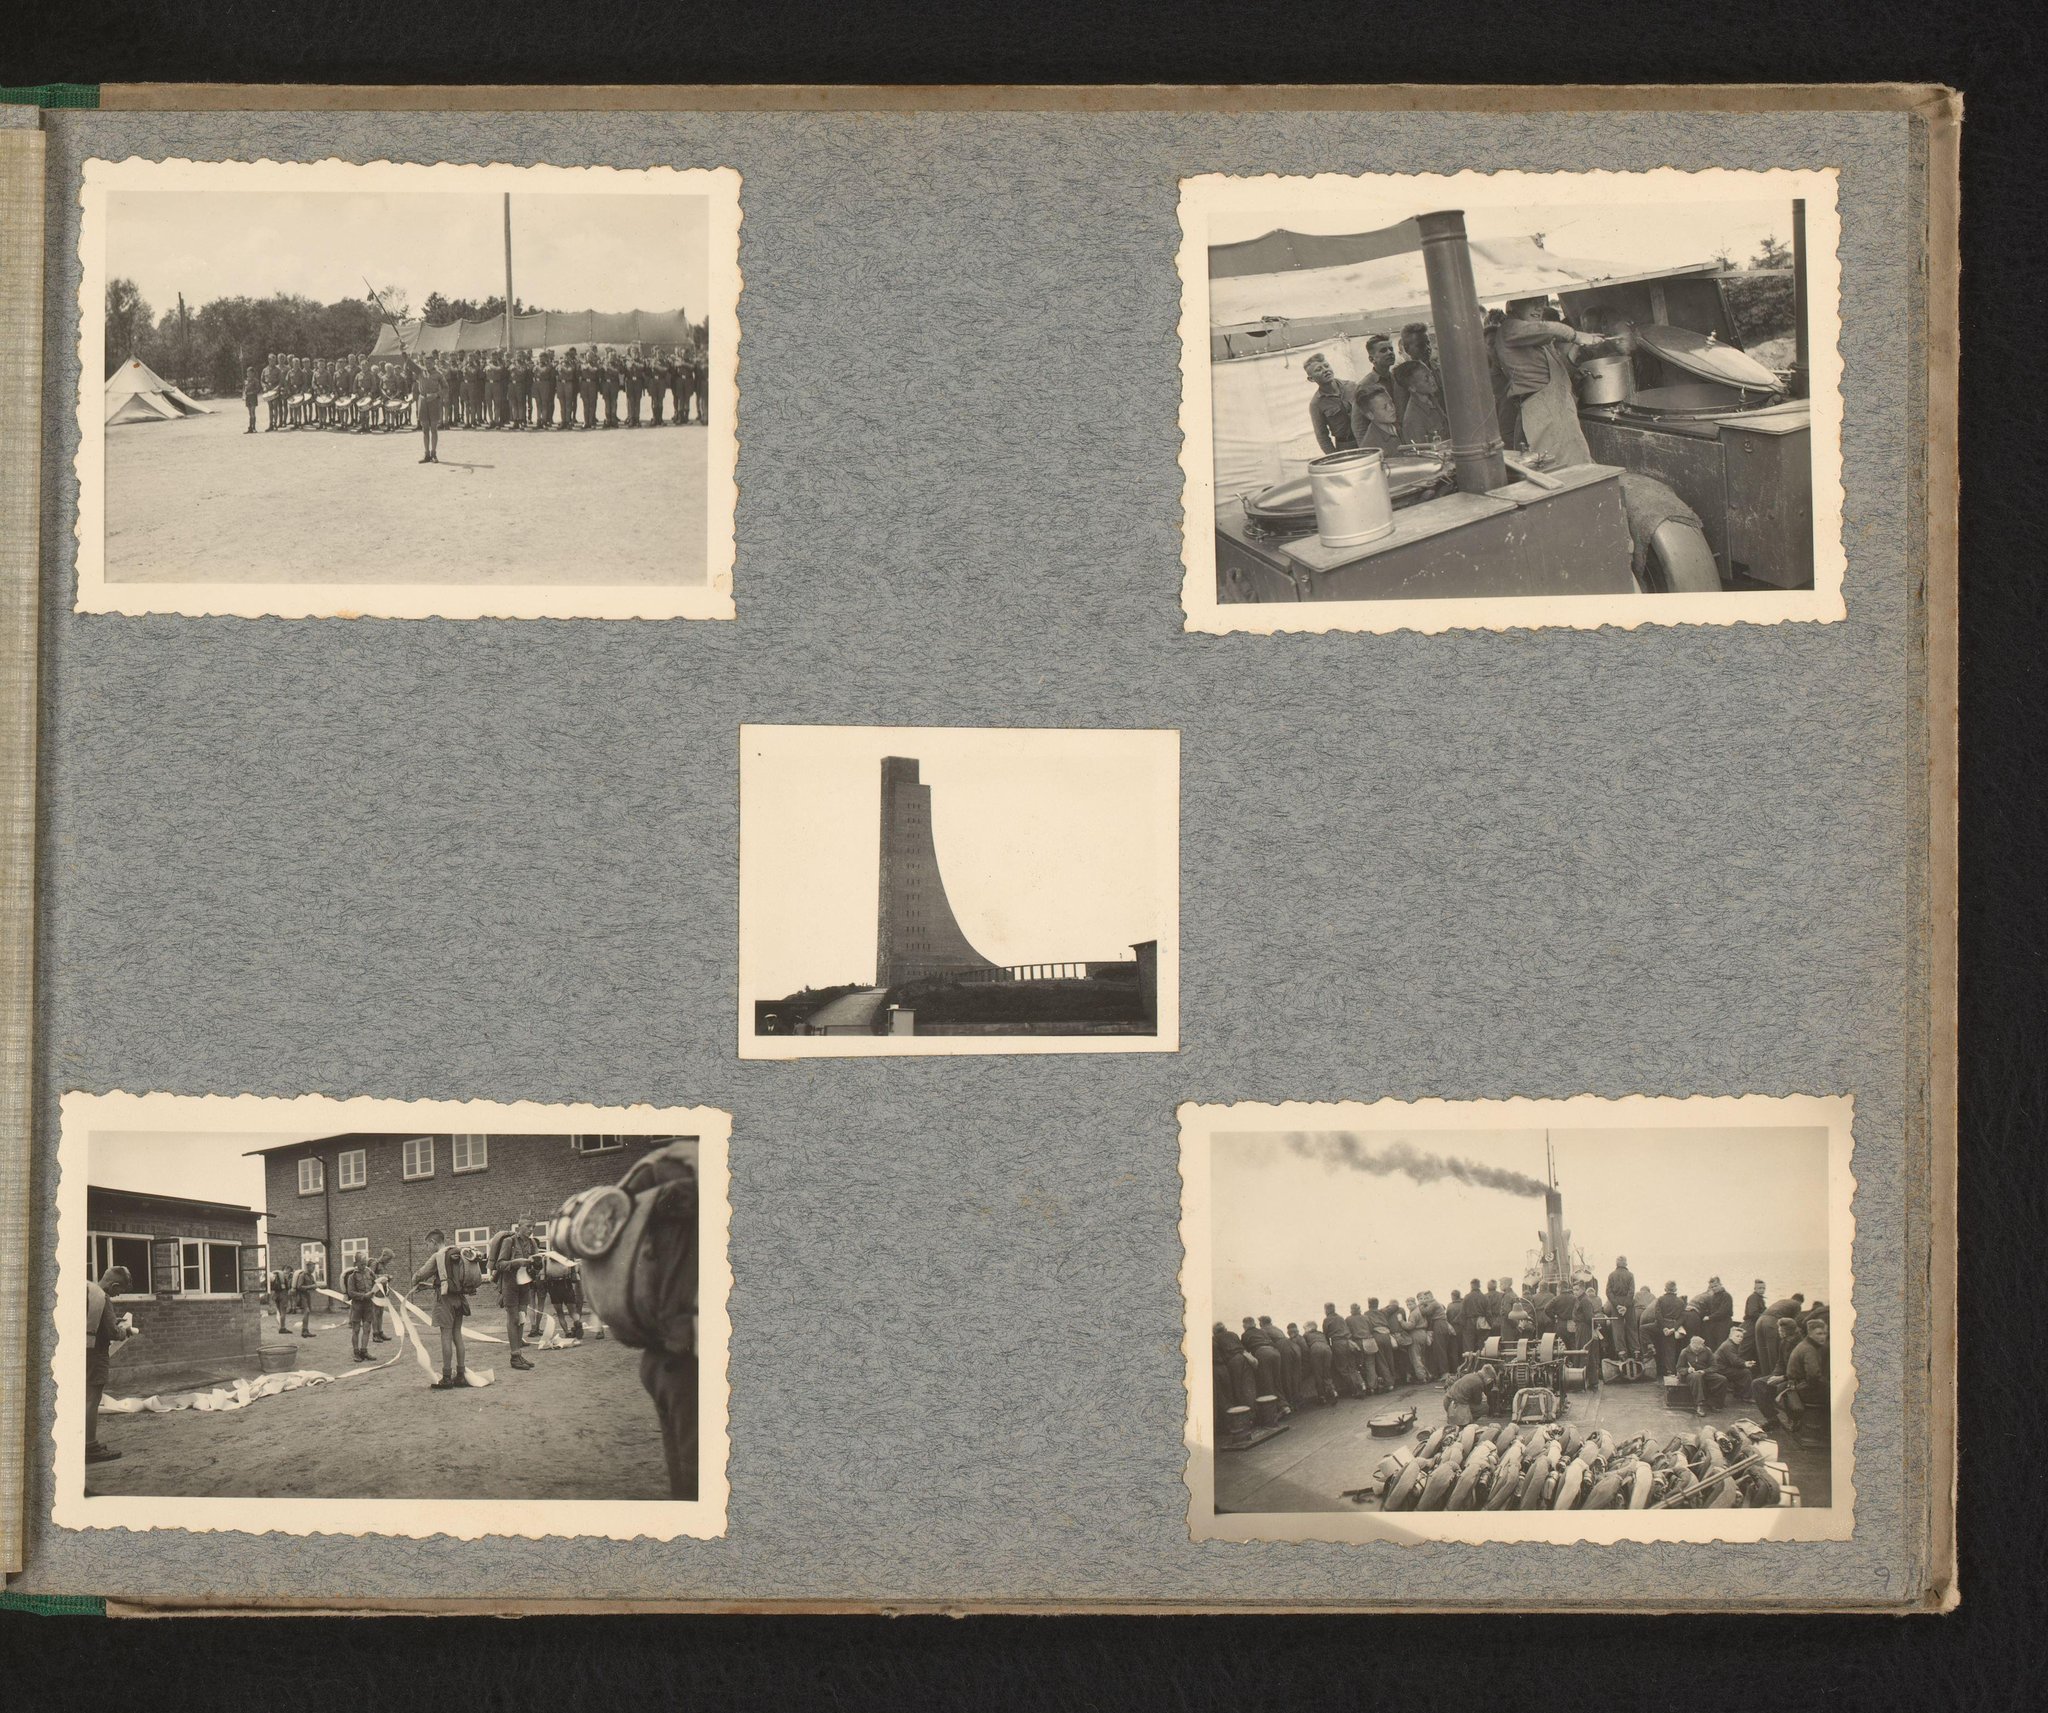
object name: photograph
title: Exercitie en boottocht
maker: Anonymous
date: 1935-1938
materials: cardboard, photographic support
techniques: gelatin silver print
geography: germany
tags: military training, preparation for battle, germany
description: Albumblad met vijf foto's van jongens van de Hitlerjugend tijdens een militaire exercitie bij het tentenkamp, bij de kombuis, oefenend met bepakking en op het dek van een schip. Landjahrlager 1935 in Wolmersdorf. Onderdeel van het Hitlerjugend fotoalbum.